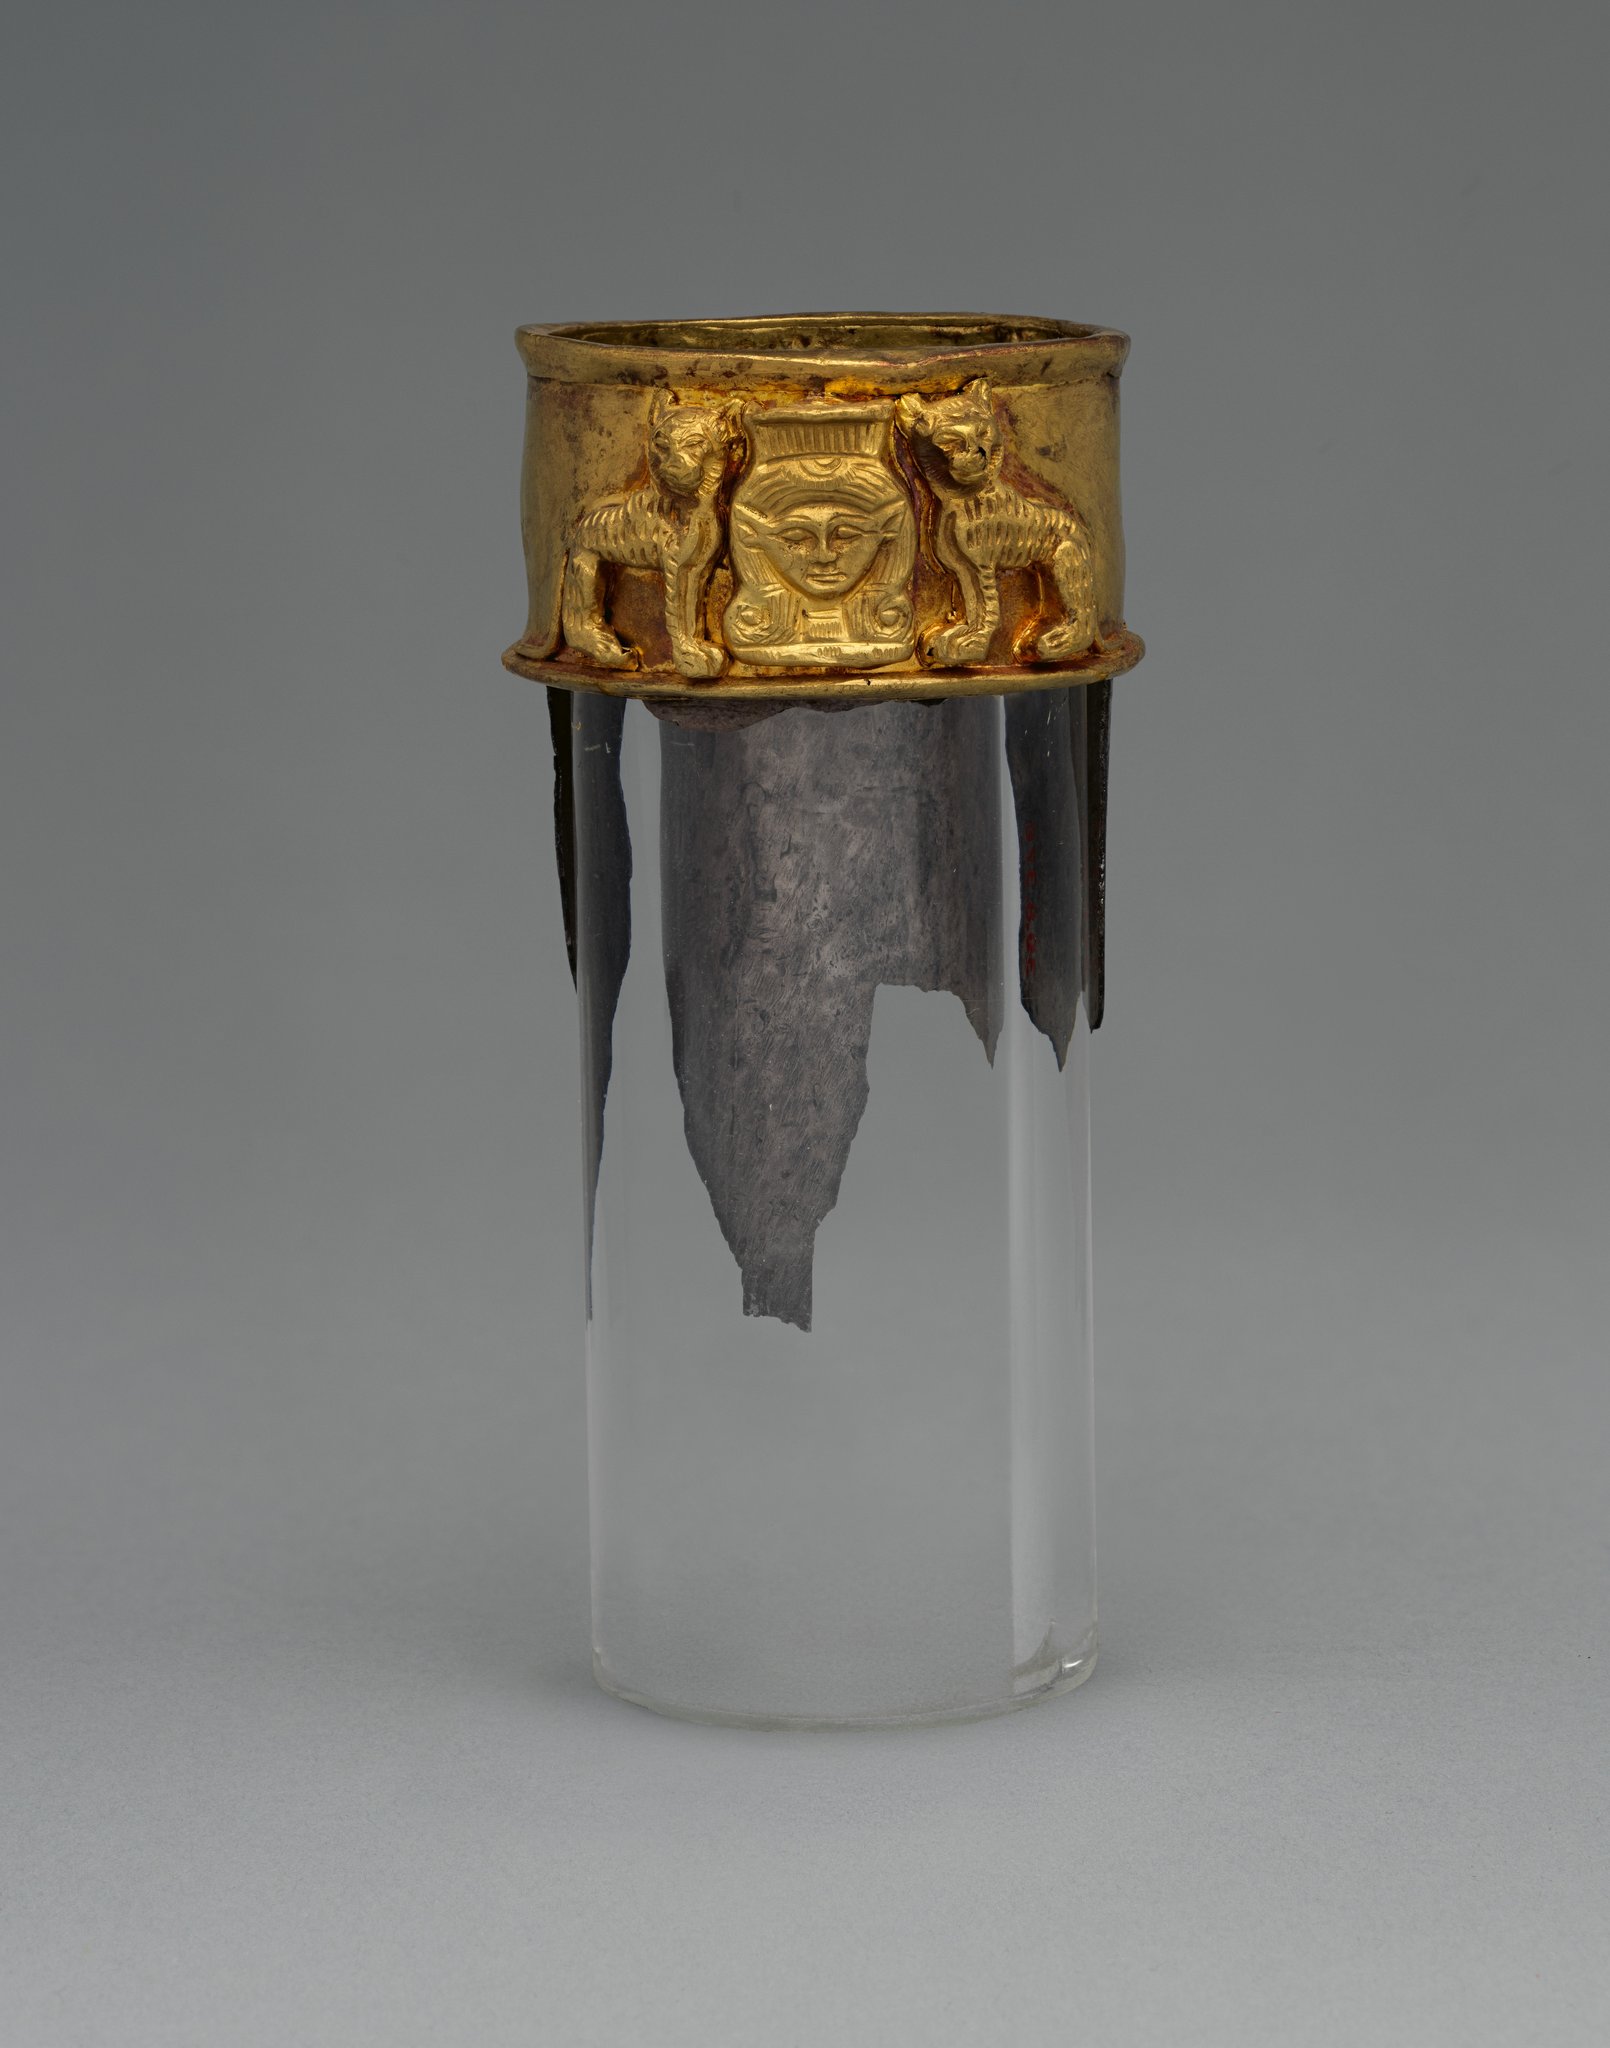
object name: situla, hathor emblem, feline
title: Neck from a vessel depicting the goddess Hathor flanked by felines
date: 1279-1213 BCE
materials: gold, silver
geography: egypt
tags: hathor,lions